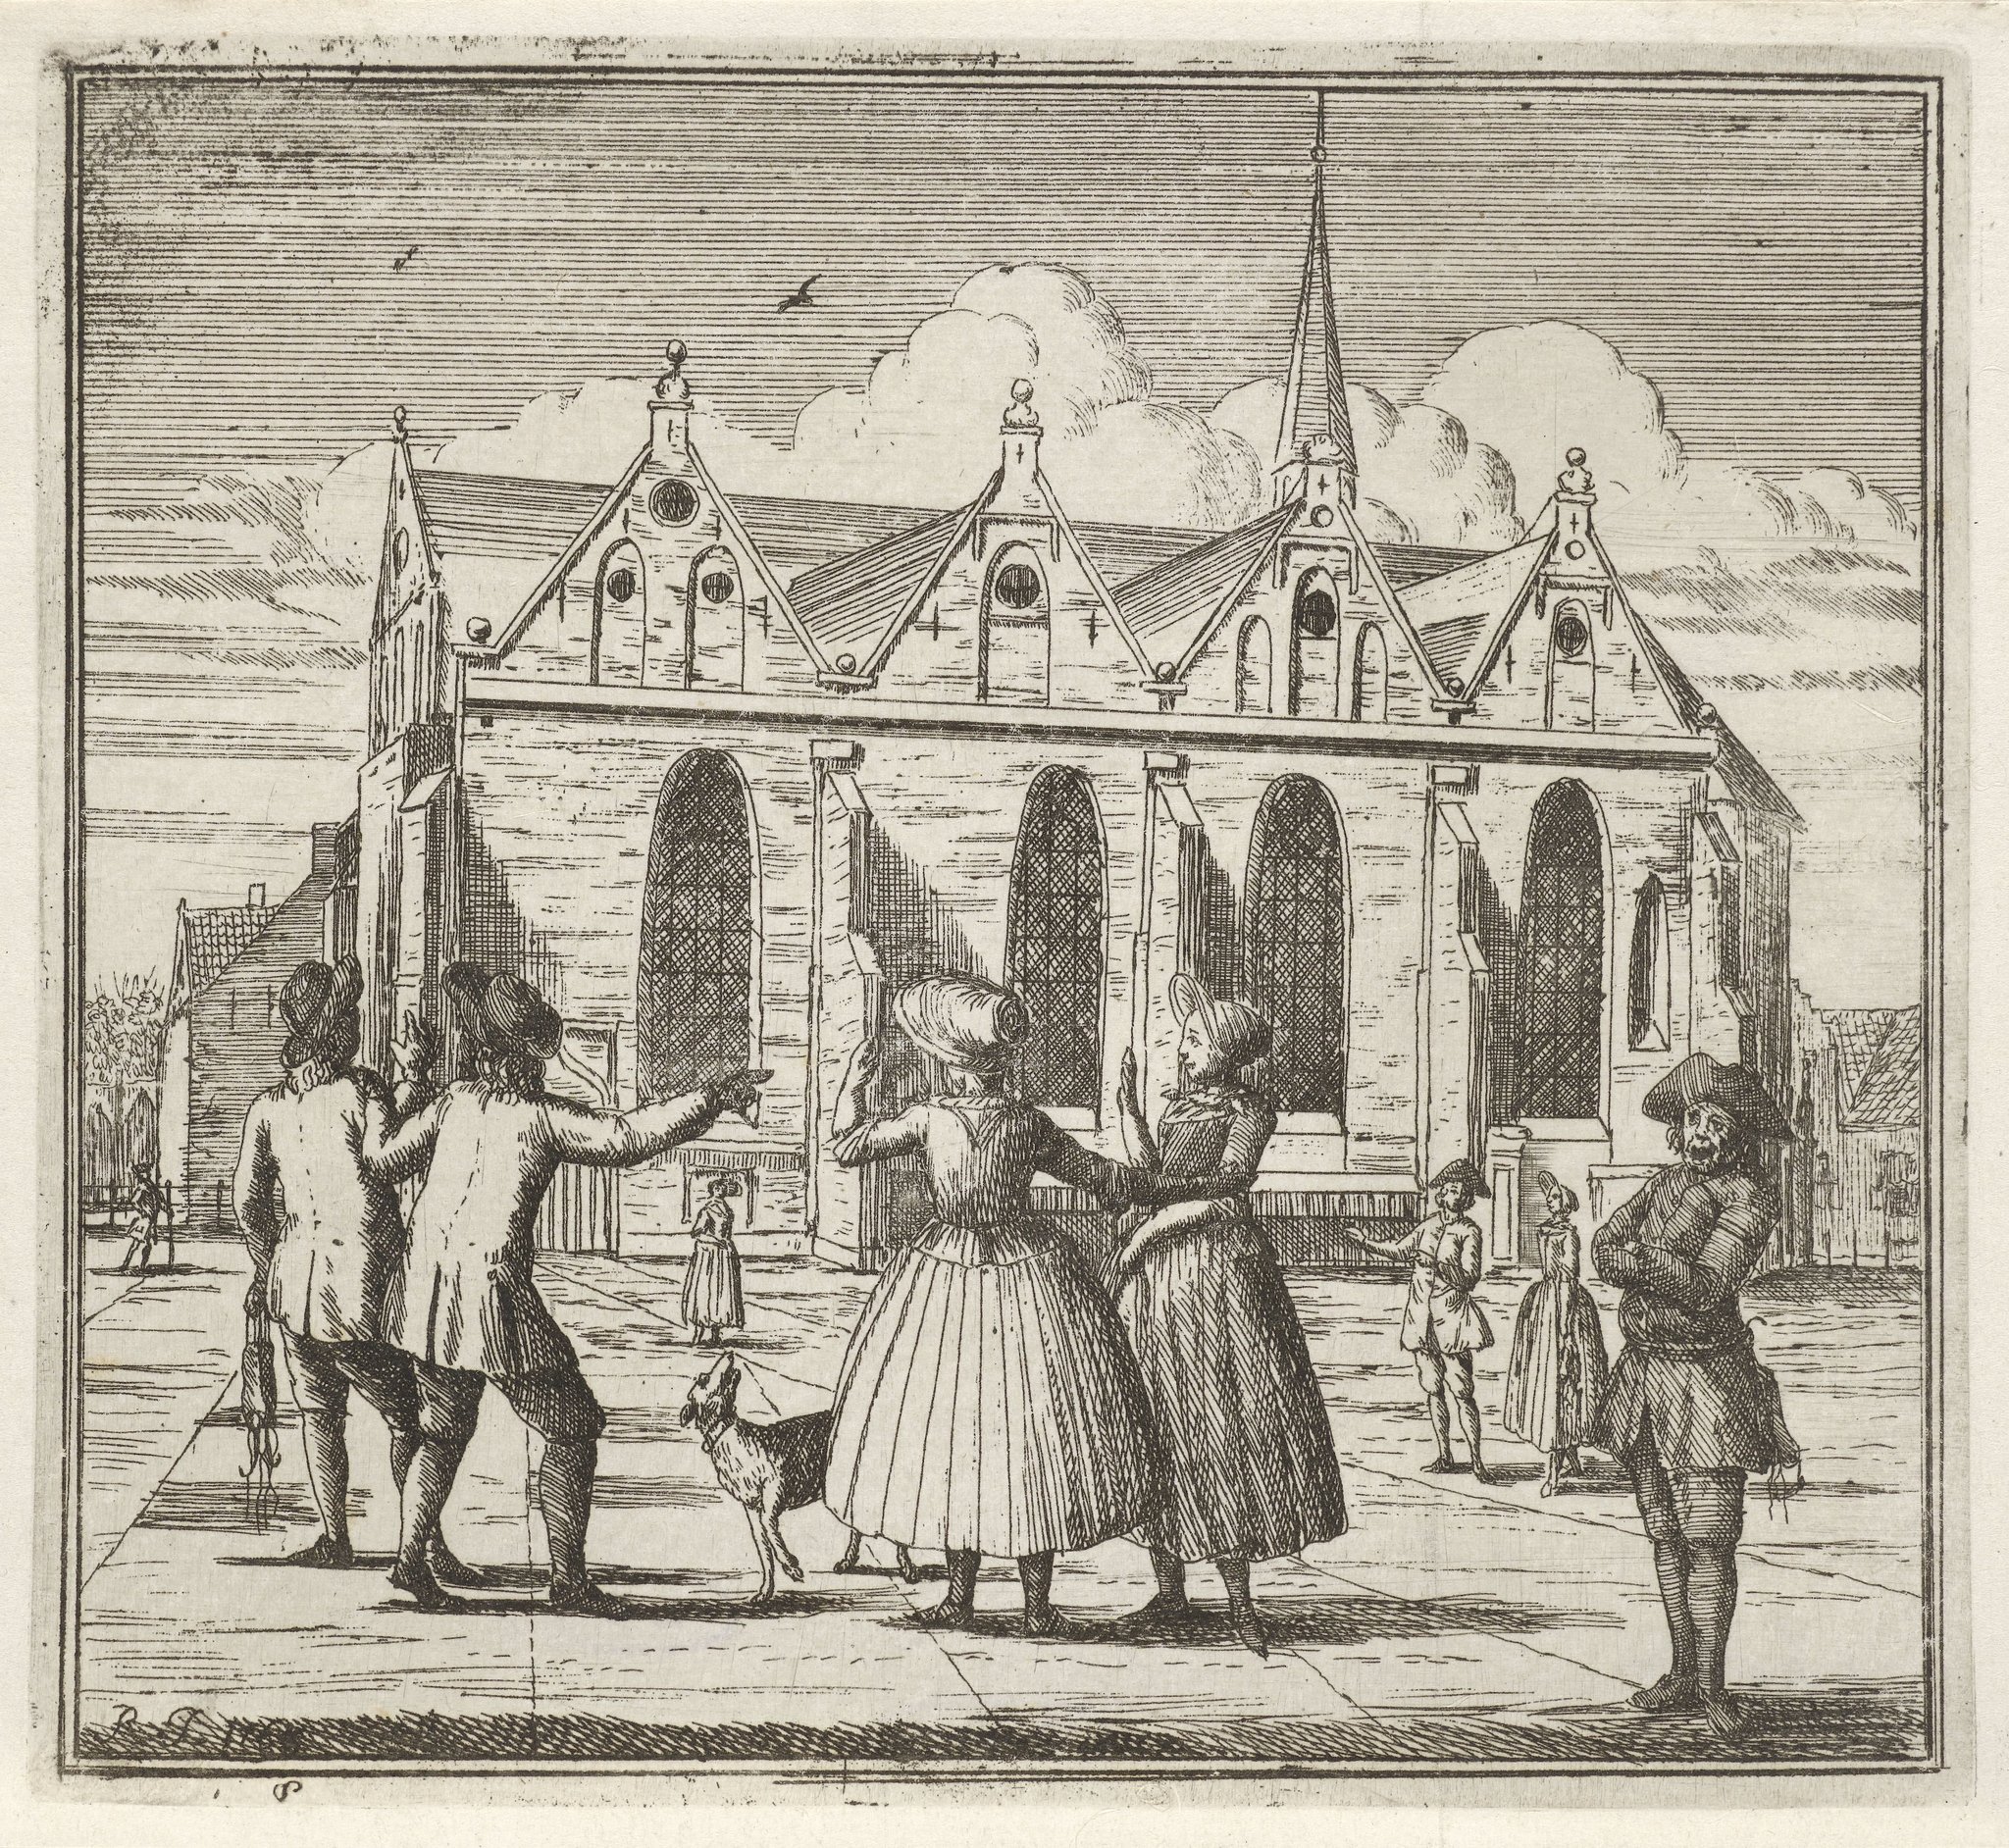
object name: print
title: Mannen en vrouwen op plein bij kerk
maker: rienk jelgerhuis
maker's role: draughtsman, print maker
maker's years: 1729-1806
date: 1765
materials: paper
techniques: engraving, etching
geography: leeuwarden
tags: building of church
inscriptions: collector's mark: Lugt 2228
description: Plein bij de Grote- of Jacobijnerkerk te Leeuwarden. Op de voorgrond twee mannen, twee vrouwen en een hond. Prent uit een serie van dertien met wintertaferelen.